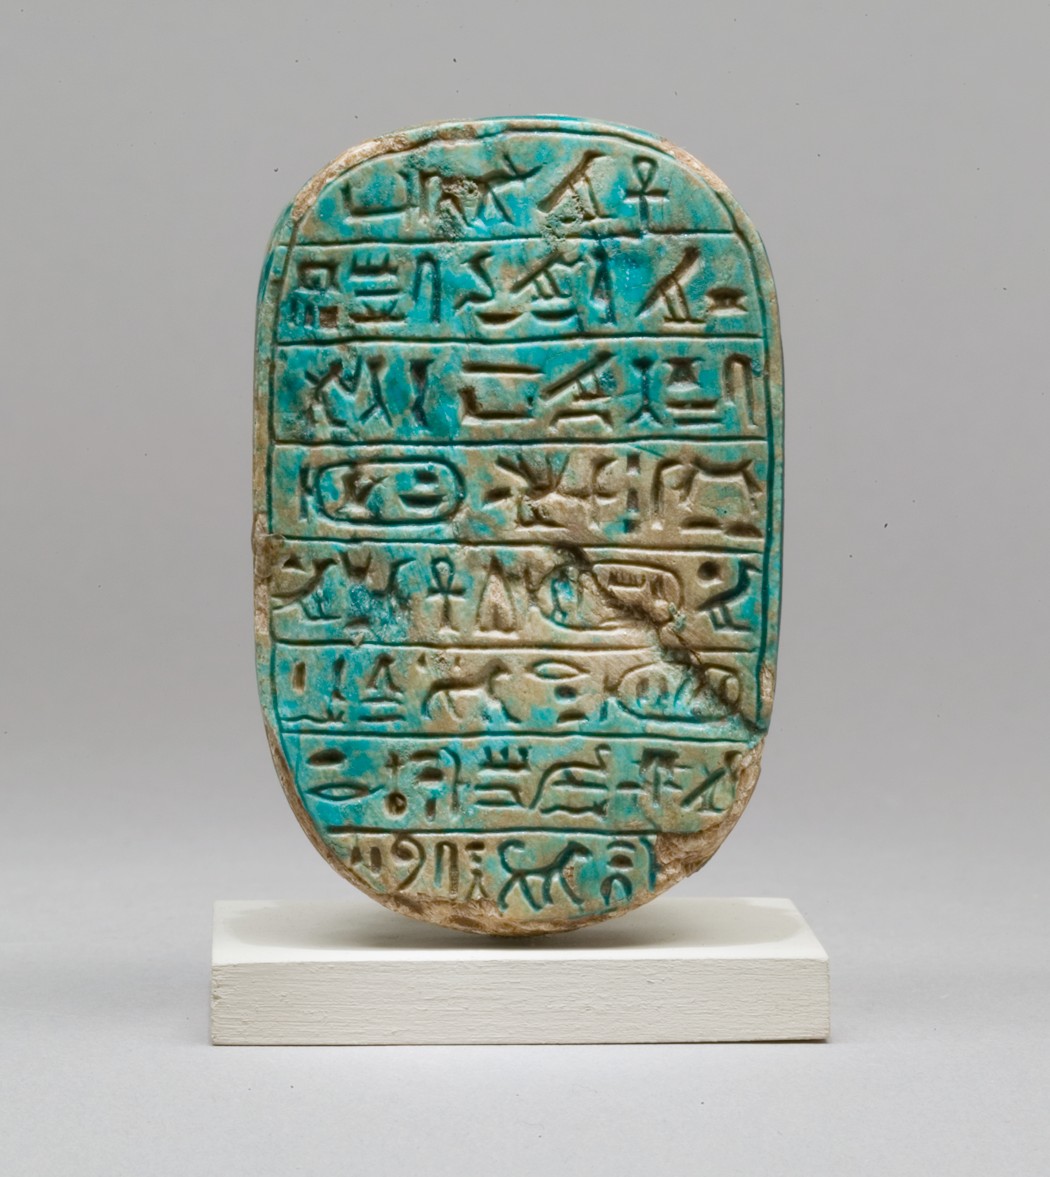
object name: scarab, commemorative, lion hunt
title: Commemorative Scarab of Amenhotep III Recording a Lion Hunt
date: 1390-1352 BCE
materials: stone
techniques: glazing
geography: egypt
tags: hieroglyphs,scarabs